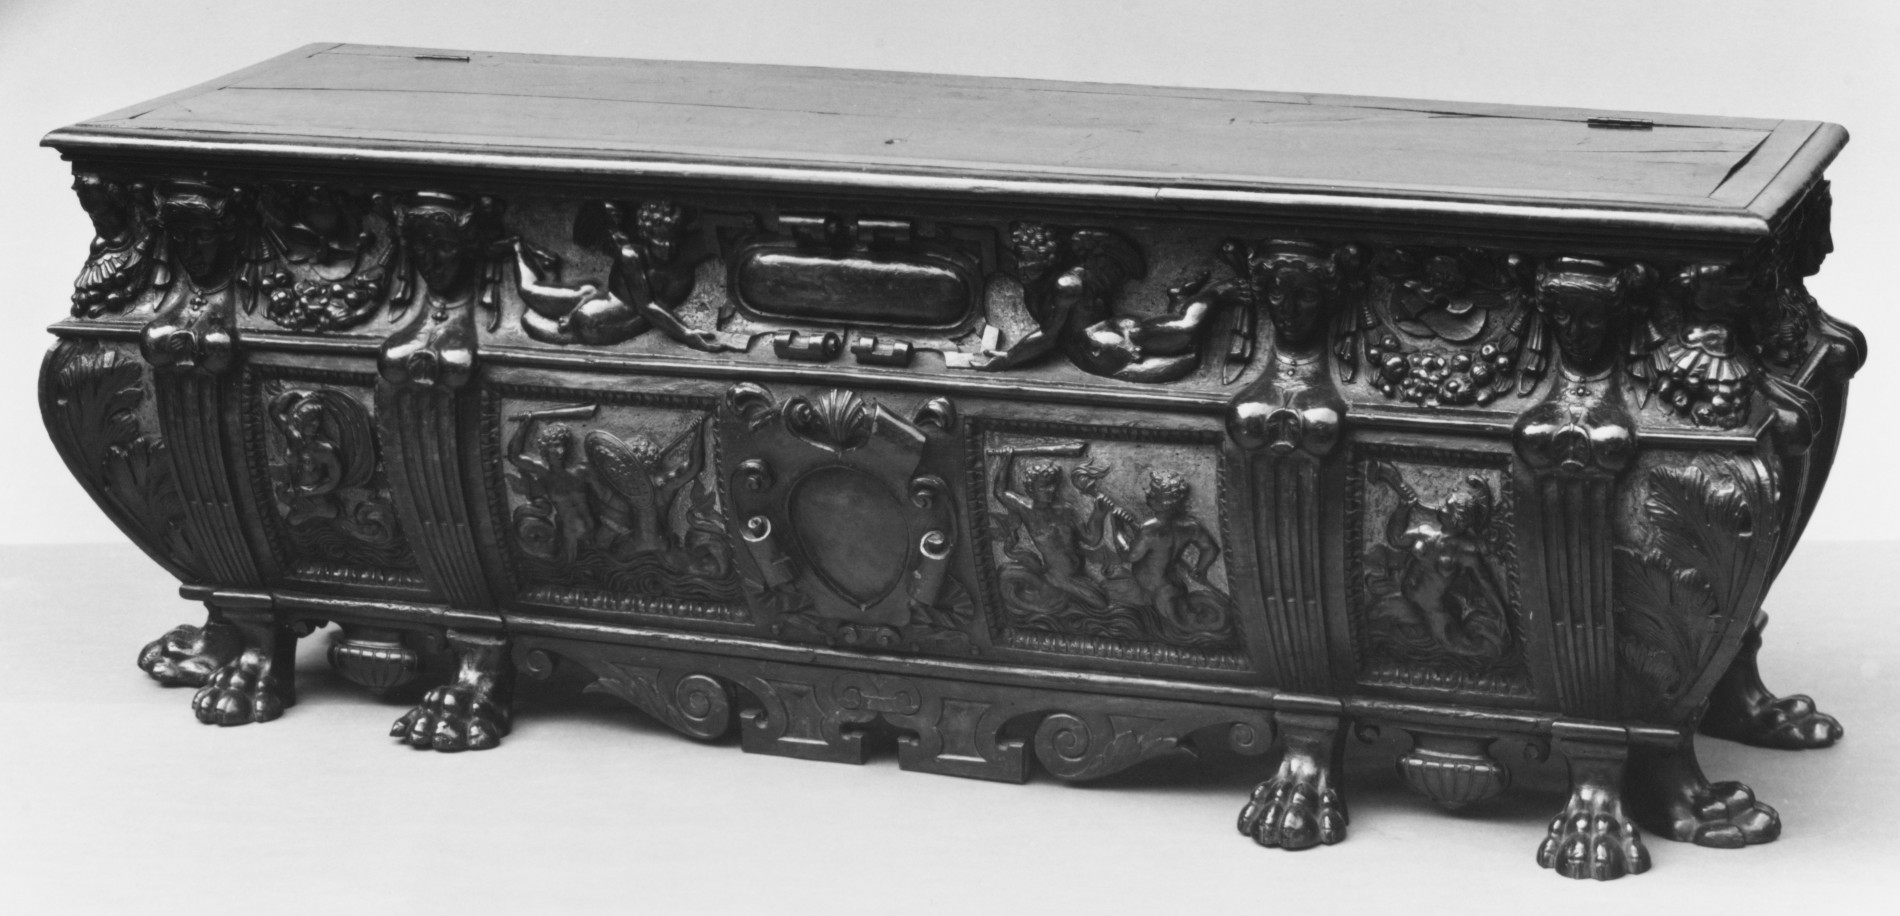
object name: marriage chest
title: Marriage chest (cassone) (one of a pair)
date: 1551-1575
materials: wood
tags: human figures